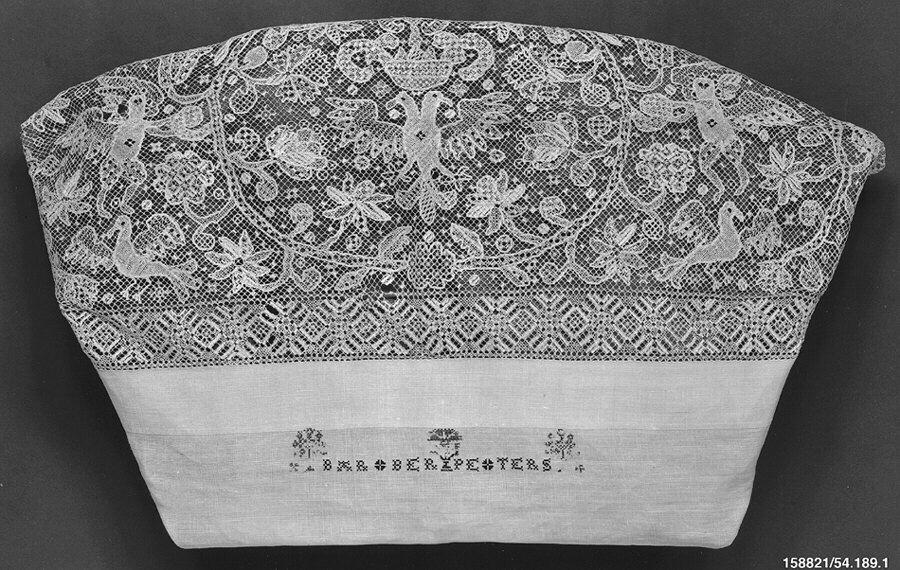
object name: pillowcase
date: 1701-1800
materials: linen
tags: birds,flowers